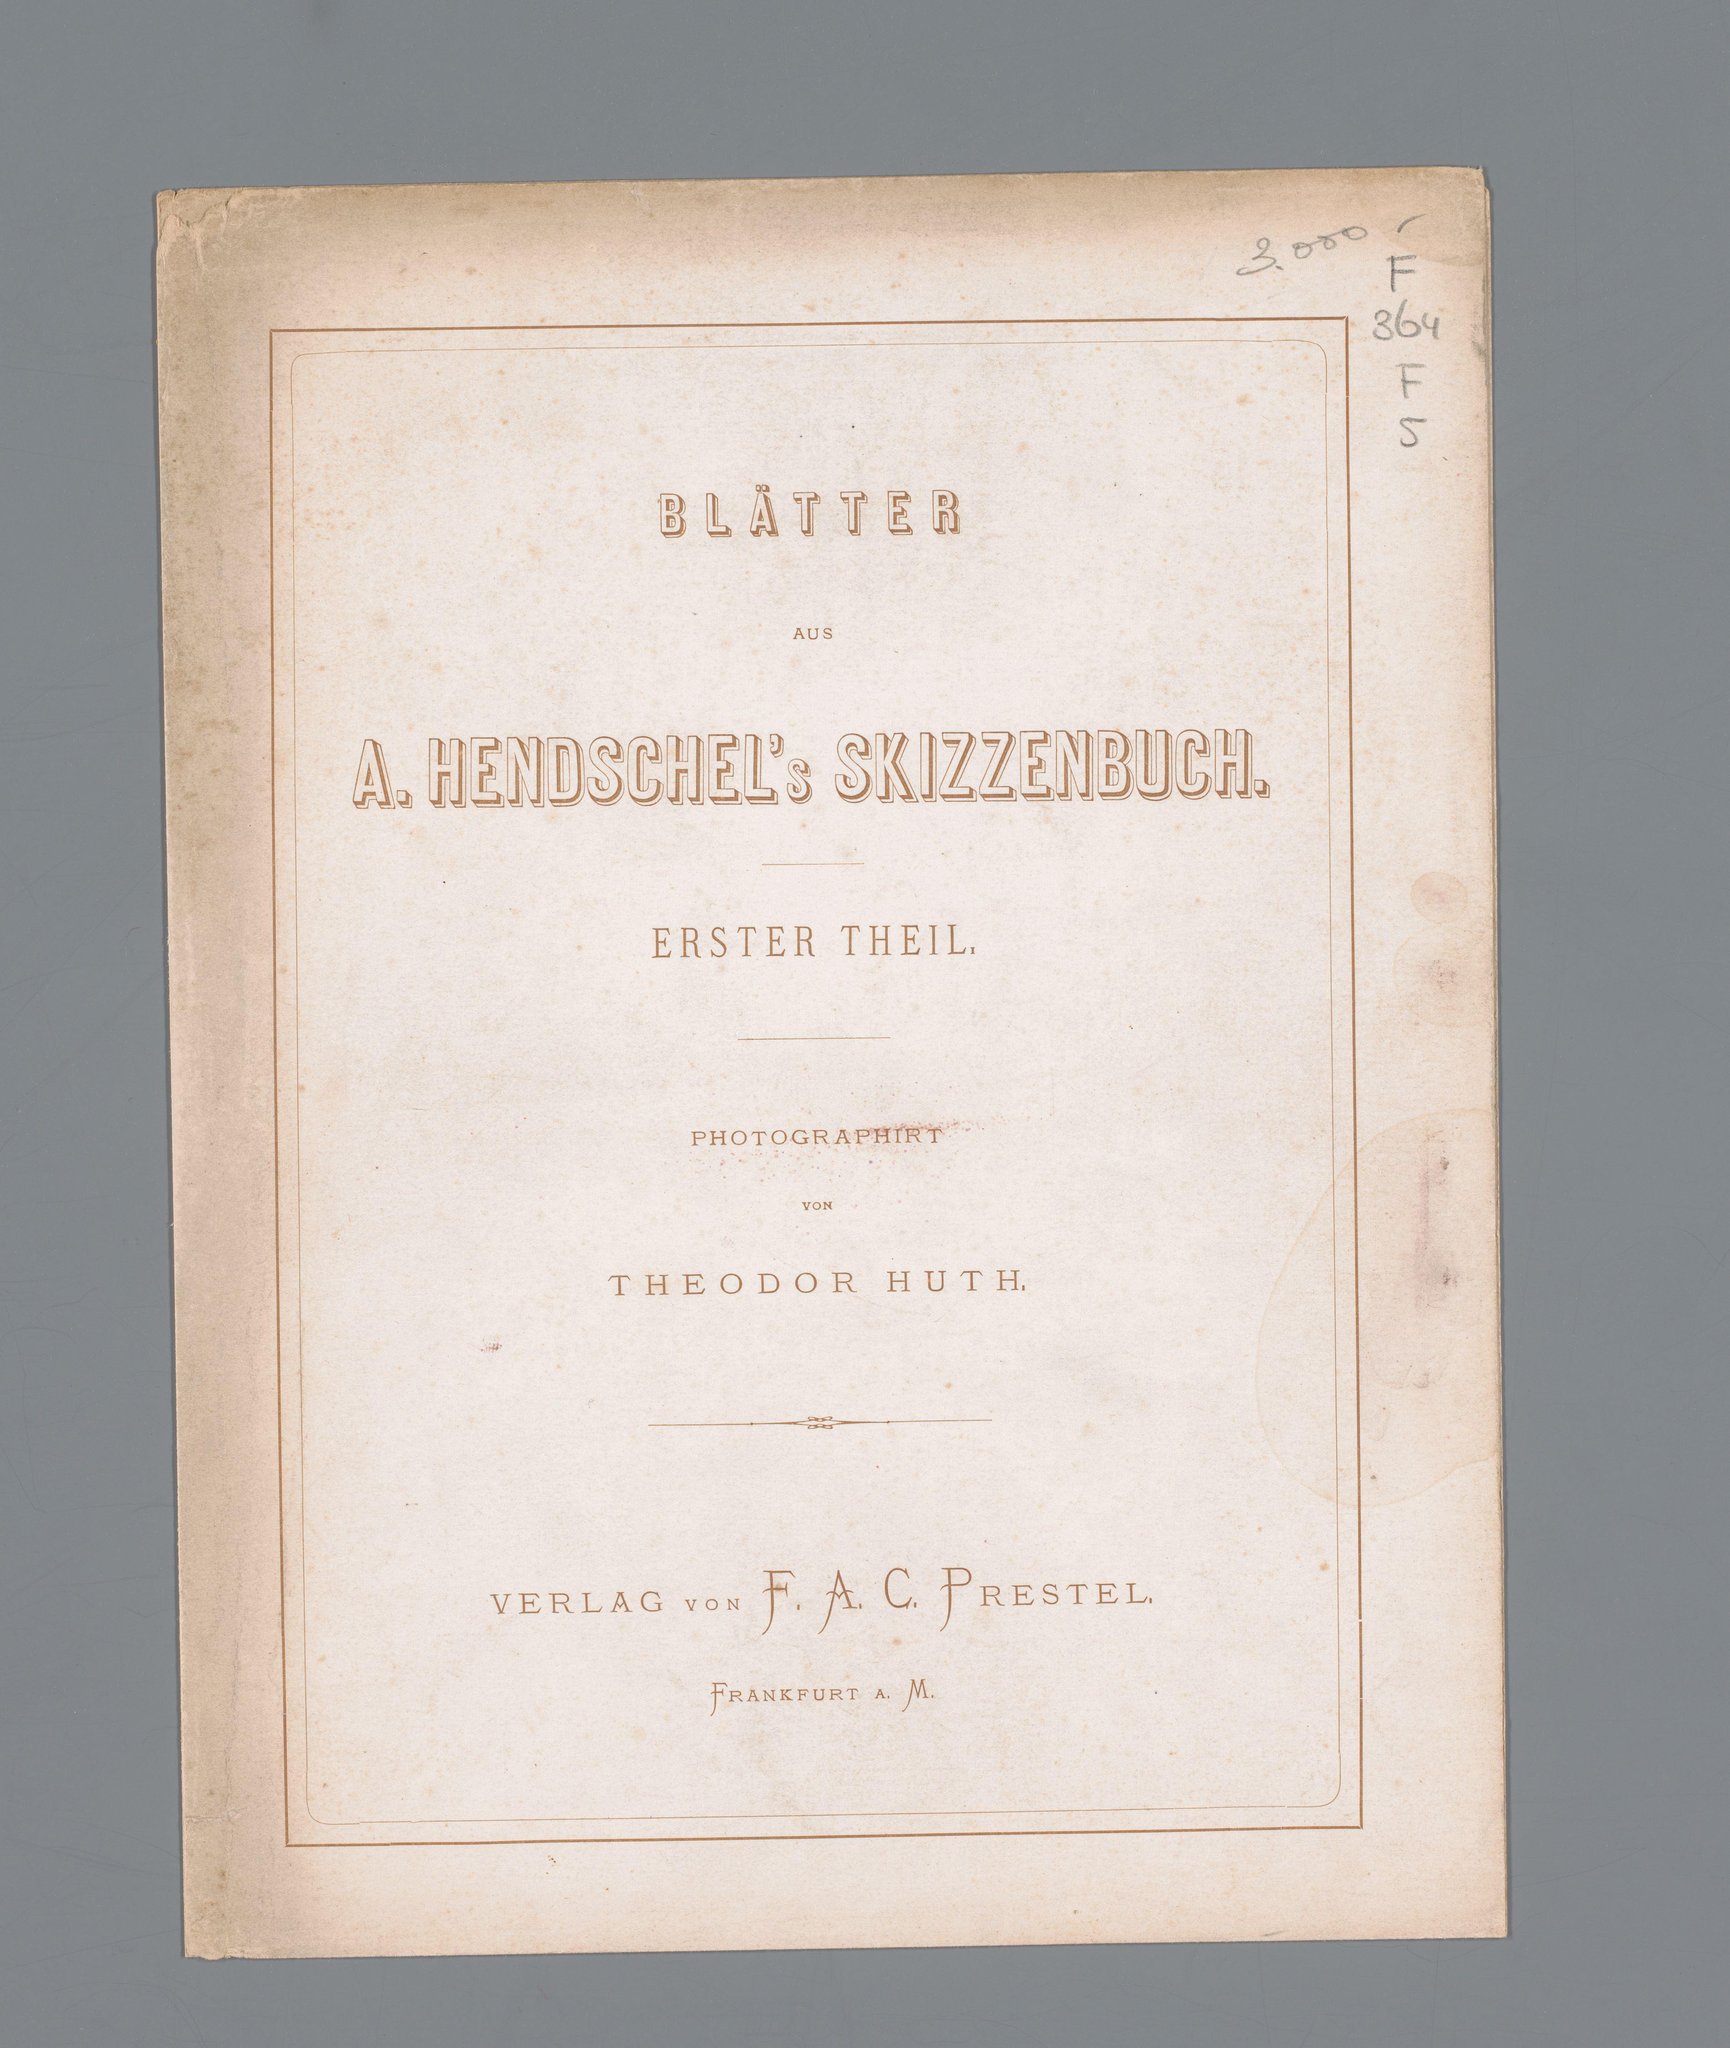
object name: wrapper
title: Blätter aus A. Hendschel's Skizzenbuch / photographirt von Theodor Huth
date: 1870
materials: cardboard, leather, linen, paper, photographic support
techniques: albumen print, printing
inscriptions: number: ‘3.000-’, date: ‘JUNE/ 1998’, retailer's mark: ‘W. SCHÄPPEL/ BUCHBINDEREI/ LEIPZIG.’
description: Omslag met 50 foto's op 48 bladen, een lijst van afbeeldingen en een titelblad.